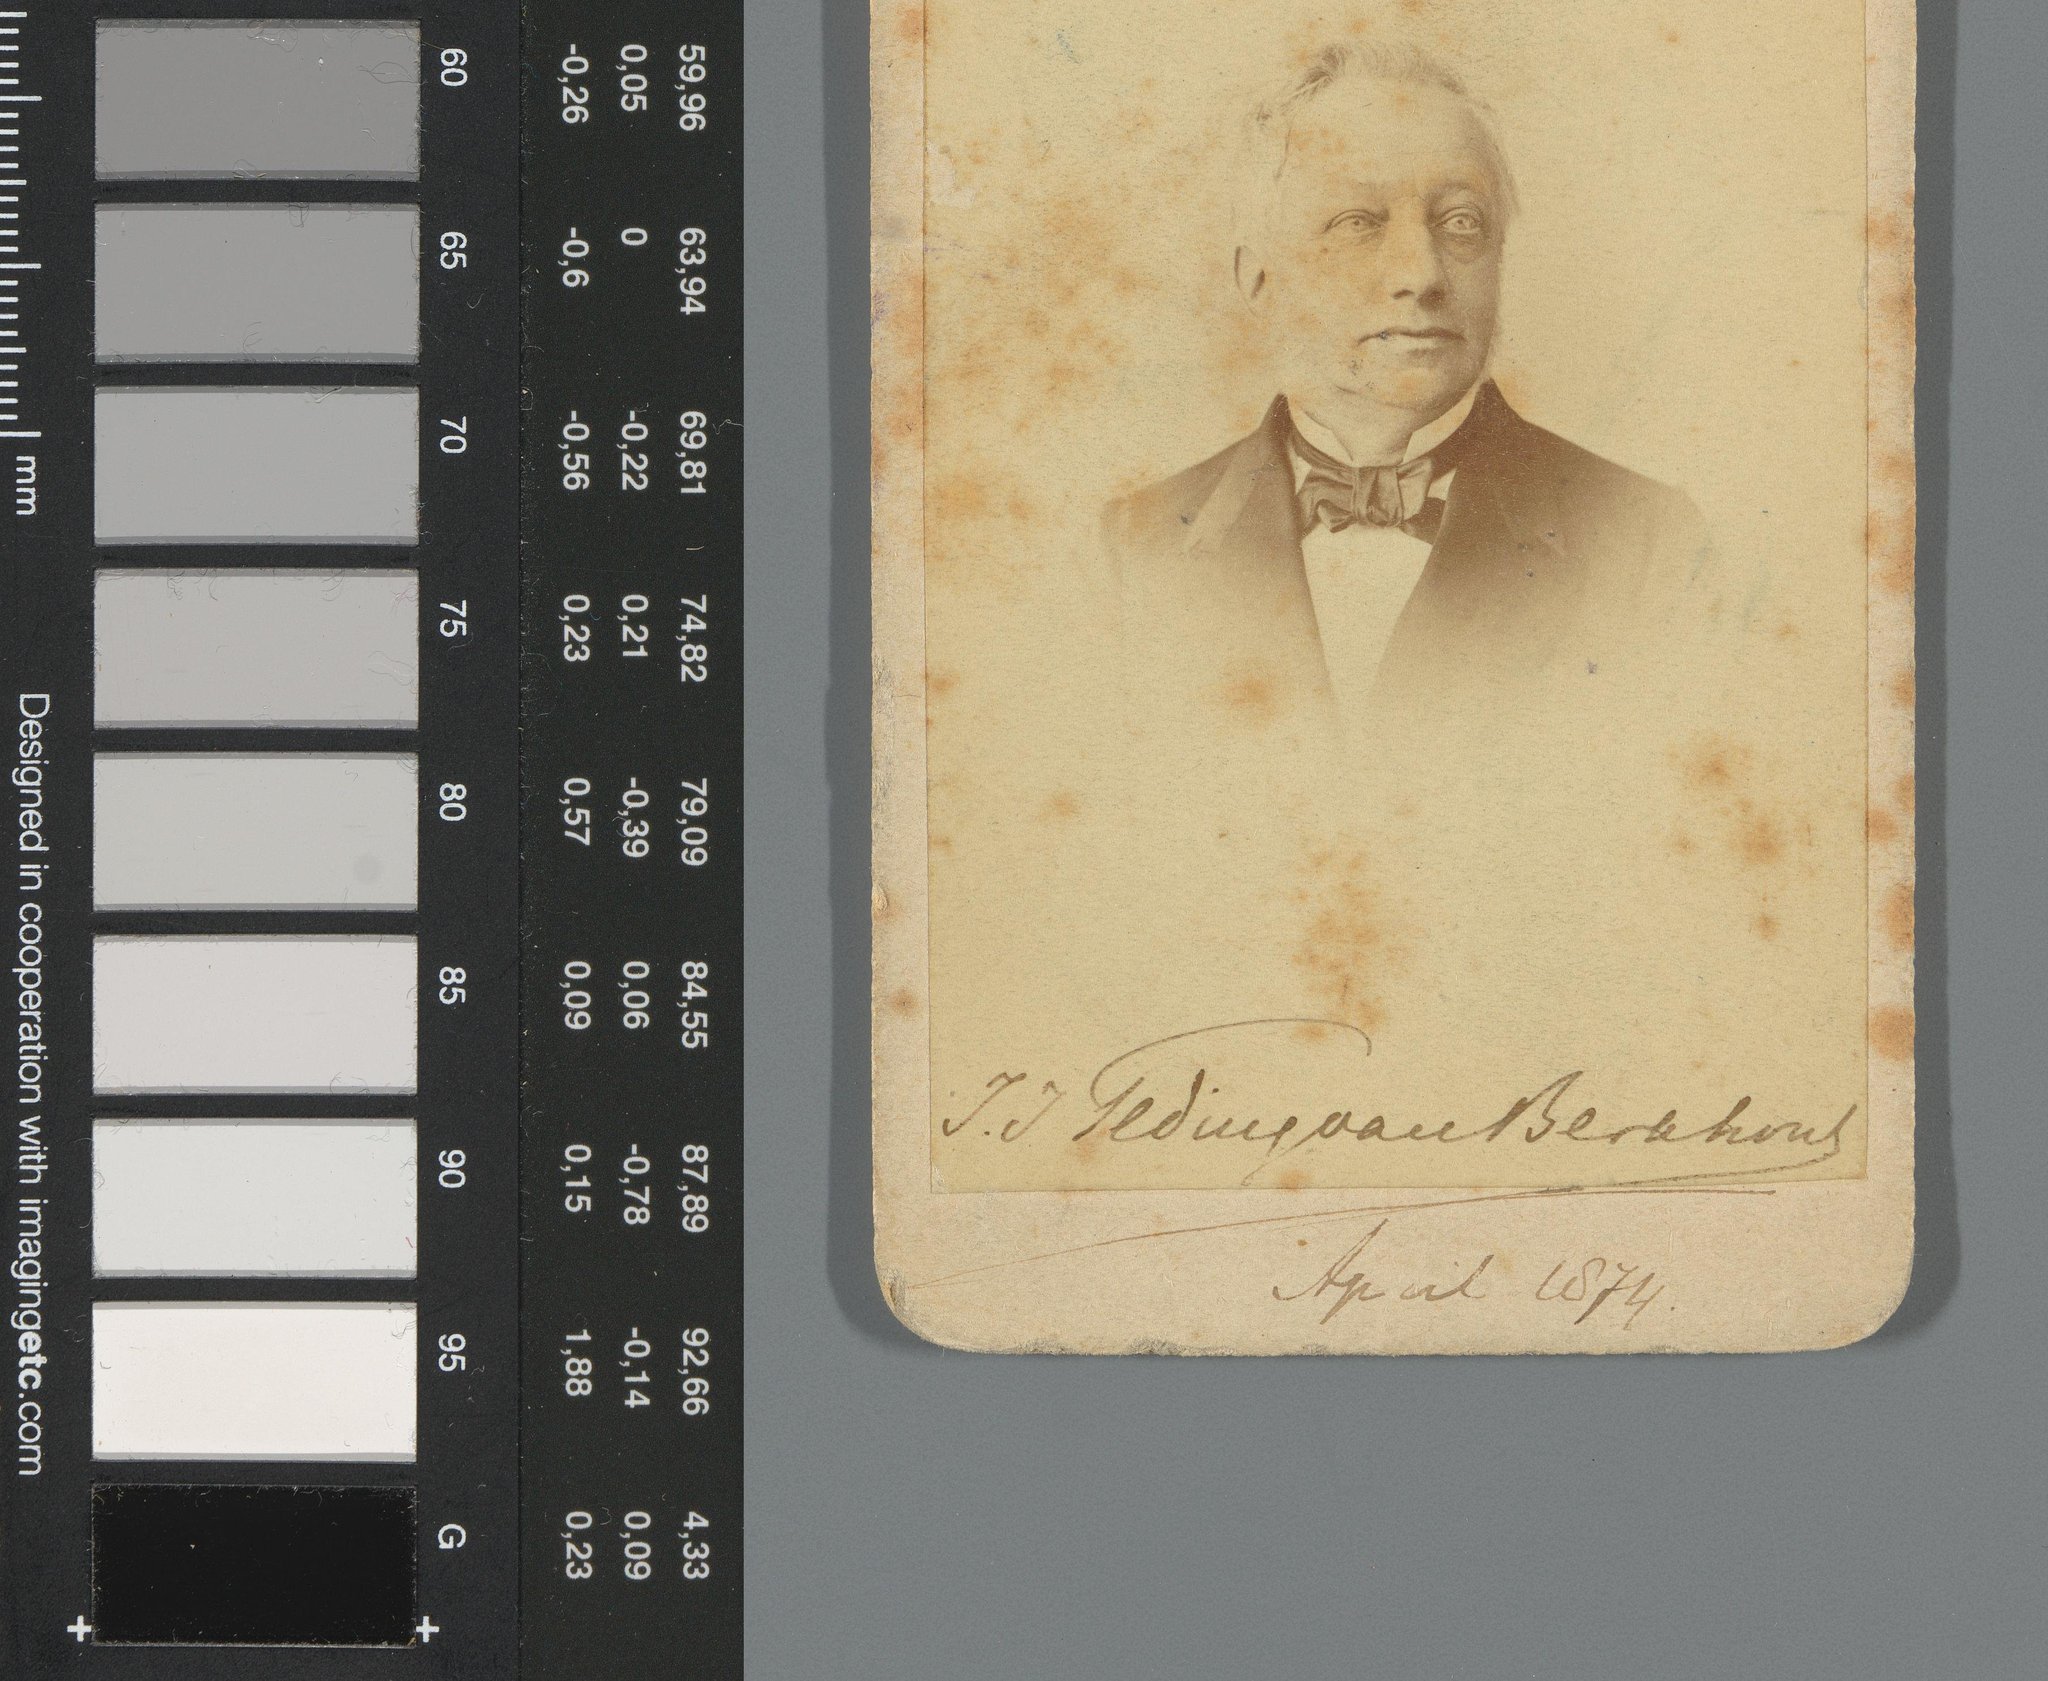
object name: photograph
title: Portret van James John Teding van Berkhout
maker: Anonymous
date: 1804-1874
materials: photographic support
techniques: photography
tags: physicist, historical persons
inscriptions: annotation: ‘ontvangen 17/1 28 van de dochter van Abraham Kuyper. Volgens haar was J.J. TvB een groot vriend en trouw medestrijder van haar vader. (...)’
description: Portret van James John Teding van Berkhout.